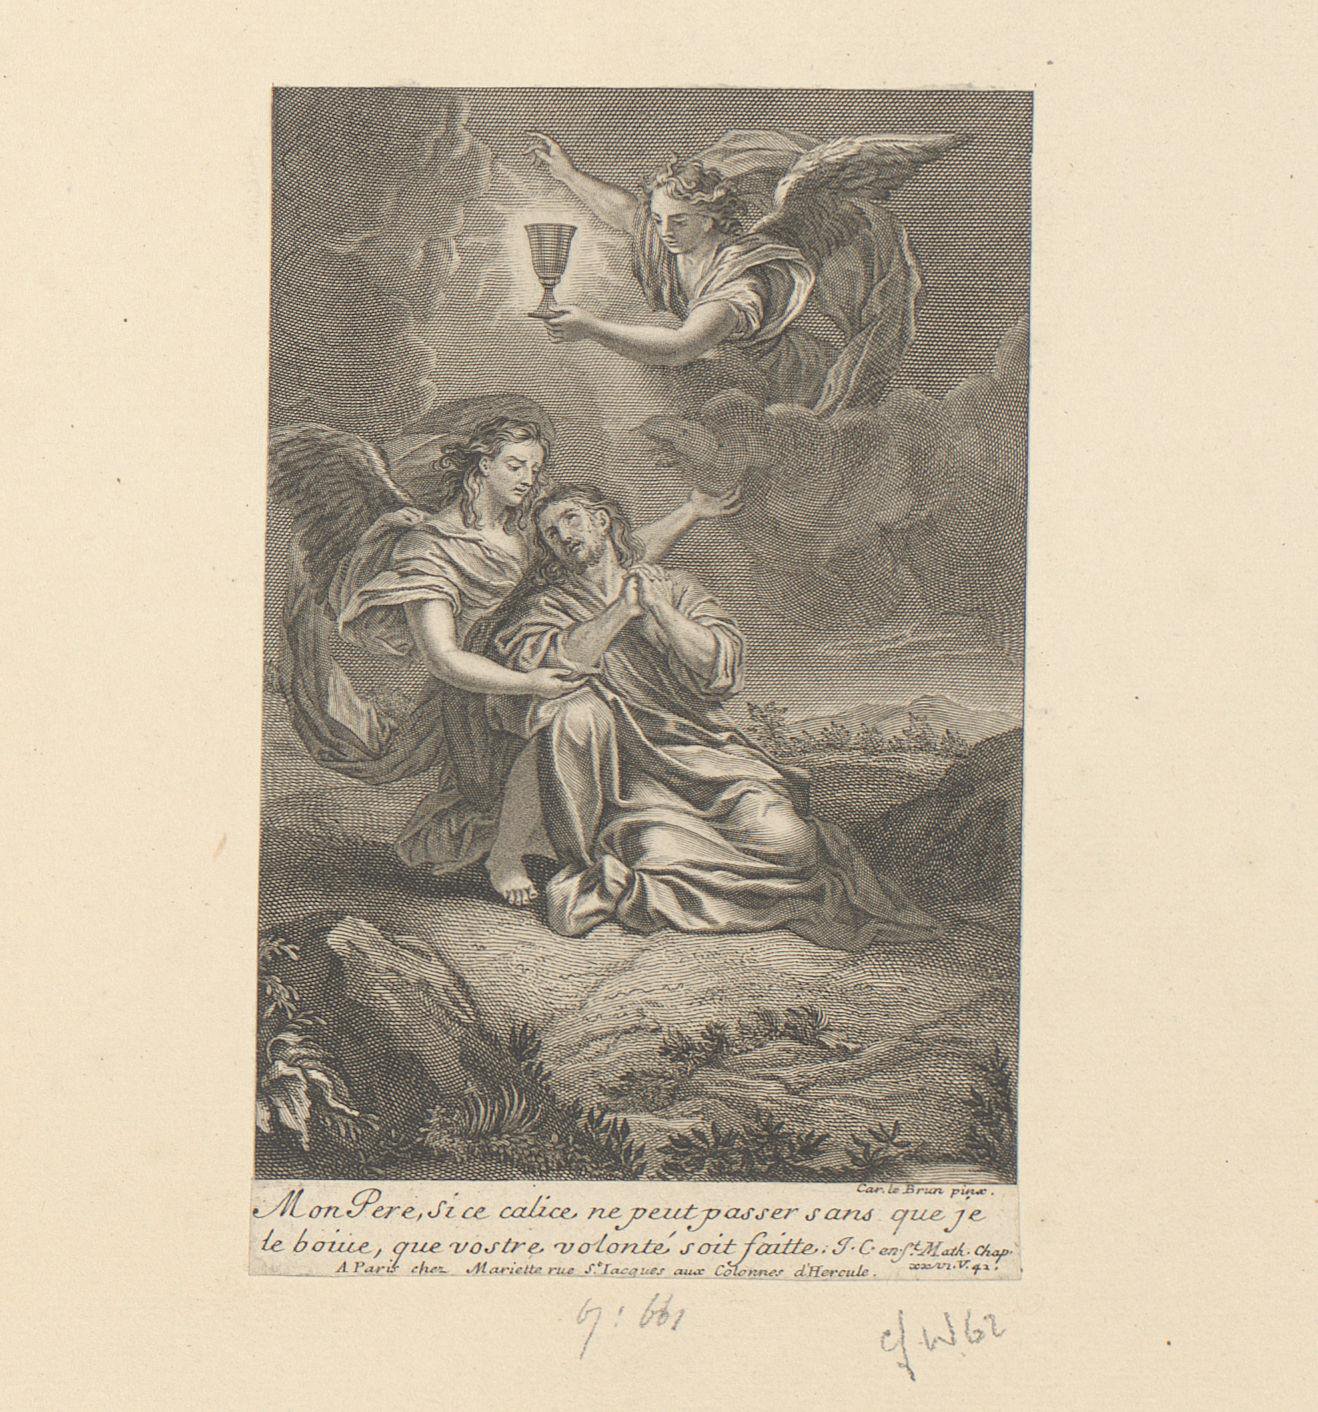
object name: album leaf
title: Christus in de hof van Getsemane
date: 1670-1742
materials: paper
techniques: engraving, etching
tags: agony of christ: to comfort him one or more angels appear to christ with chalice and/or cross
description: Deze prent maakt deel uit van een album.